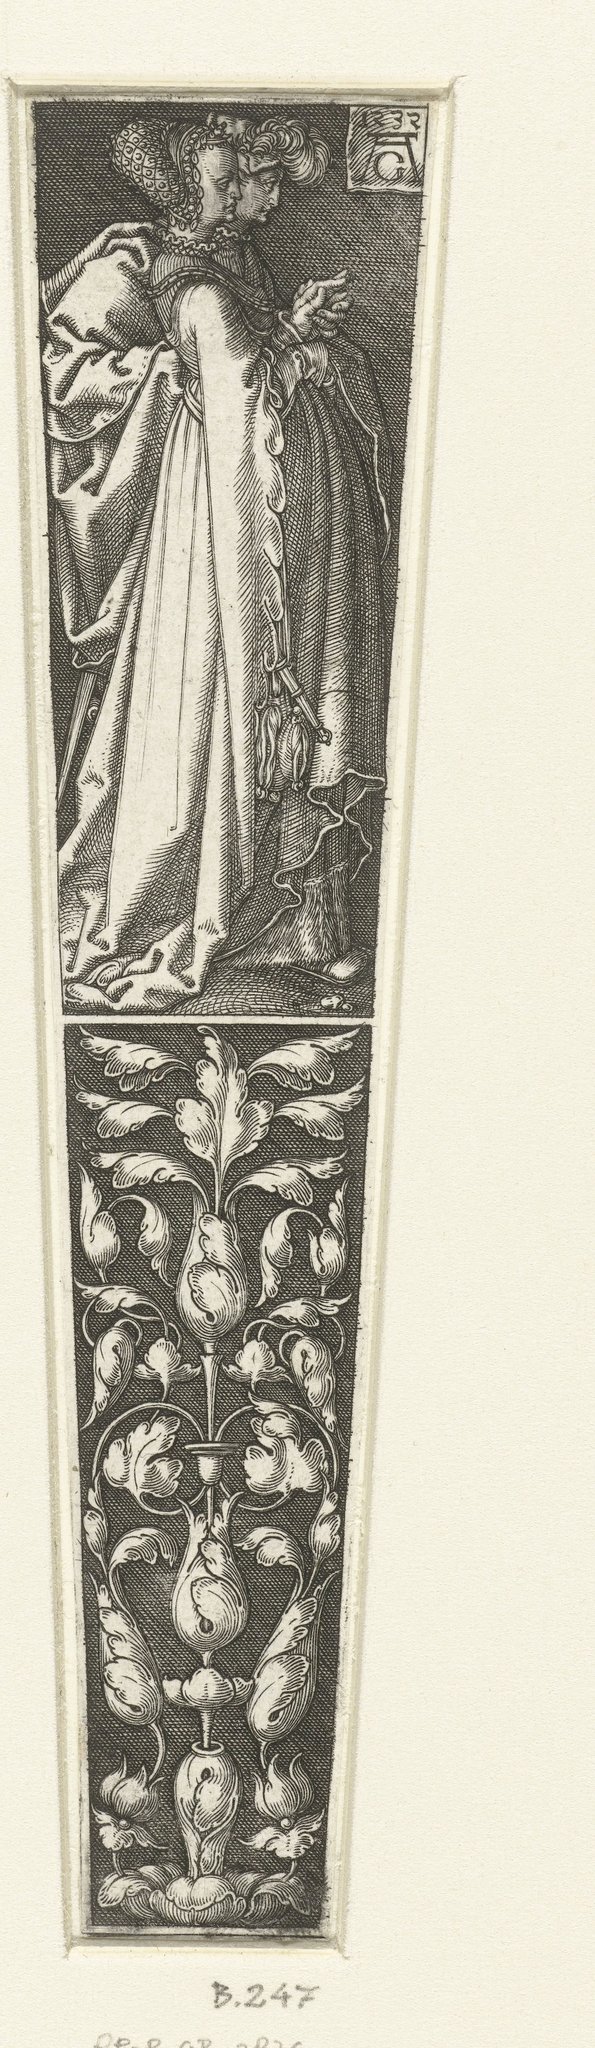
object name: print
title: Ontwerp voor een schede met een dame en een heer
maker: heinrich aldegrever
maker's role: draughtsman, print maker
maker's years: 1502-1561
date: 1532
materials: paper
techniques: engraving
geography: germany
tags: couple of lovers, foliage, tendrils, branches ~ ornament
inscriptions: collector's mark: ‘33’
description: Ontwerp voor een dolkschede. Het onderste gedeelte is gedecoreerd met bladranken. Daarboven staan een heer en een dame hand in hand.